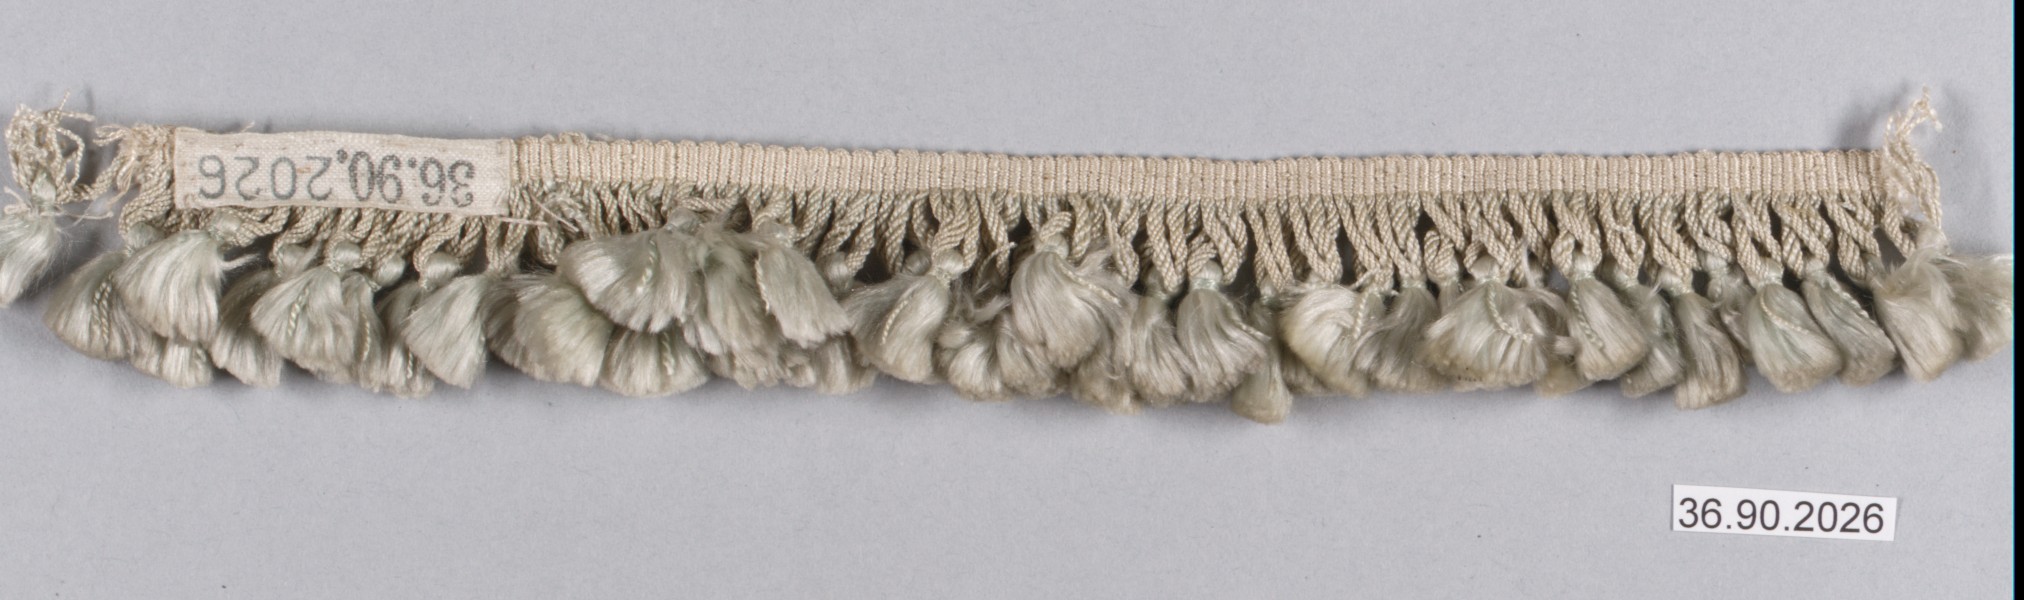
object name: fringe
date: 1701-1800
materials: silk